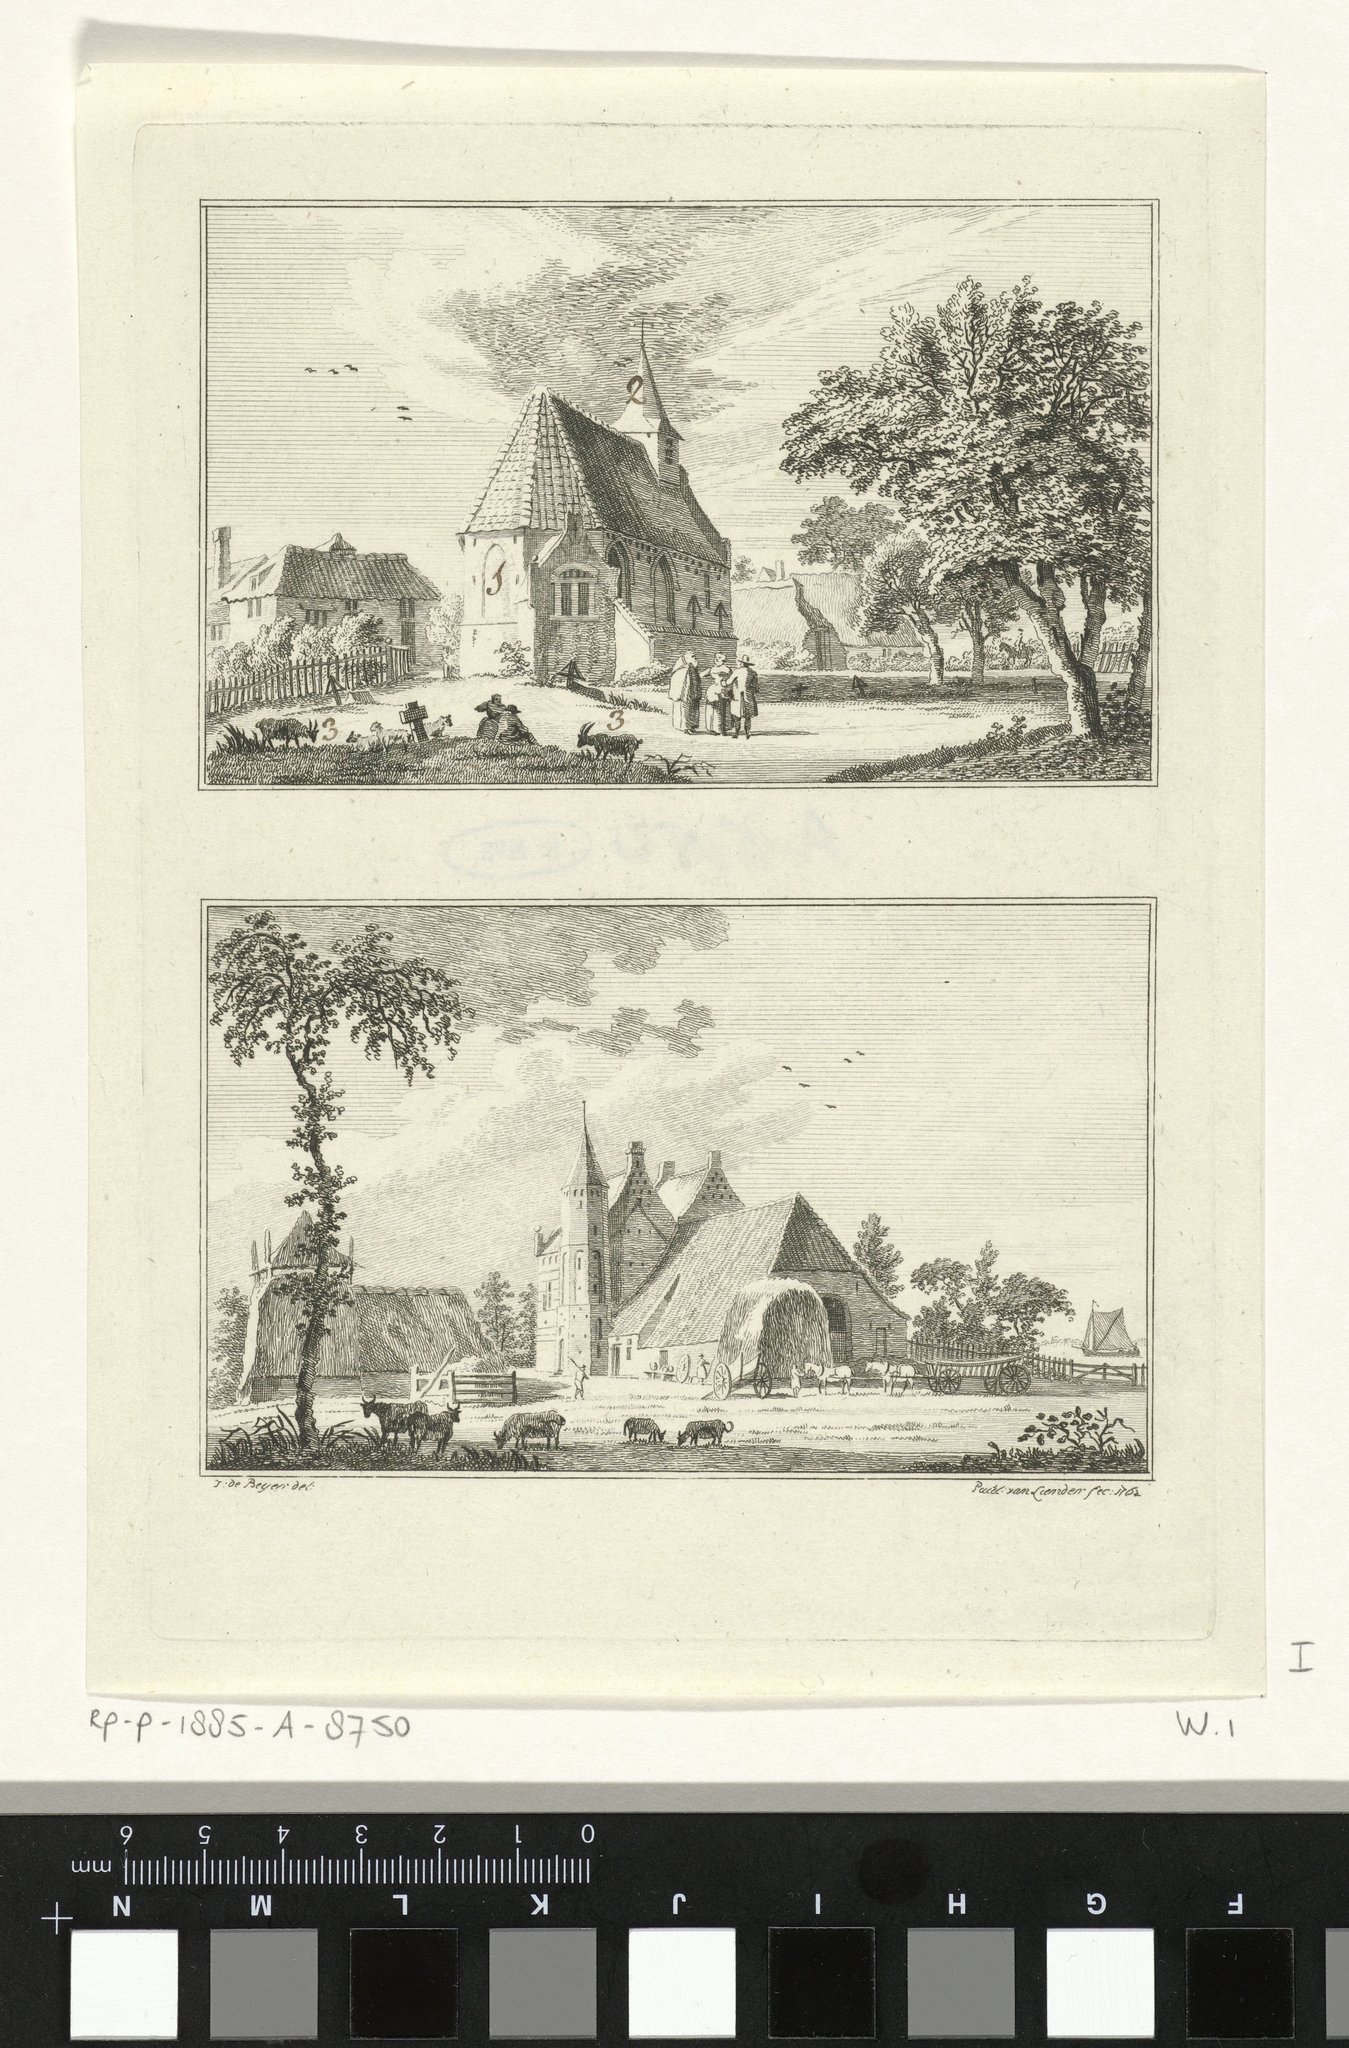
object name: print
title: Kapel in Loo en het Huis Loowaerd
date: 1762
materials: paper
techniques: etching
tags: parts of church exterior and annexes: chapel - qq - small church, chapel, farm or solitary house in landscape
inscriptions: collector's mark: Lugt 2228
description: Twee voorstellingen van één plaat. Gezicht op de kapel te Loo (boven) en het Huis te Loowaerd (onder). De prent maakt deel uit van een 100-delige serie met gezichten op dorpen en steden te Kleef.